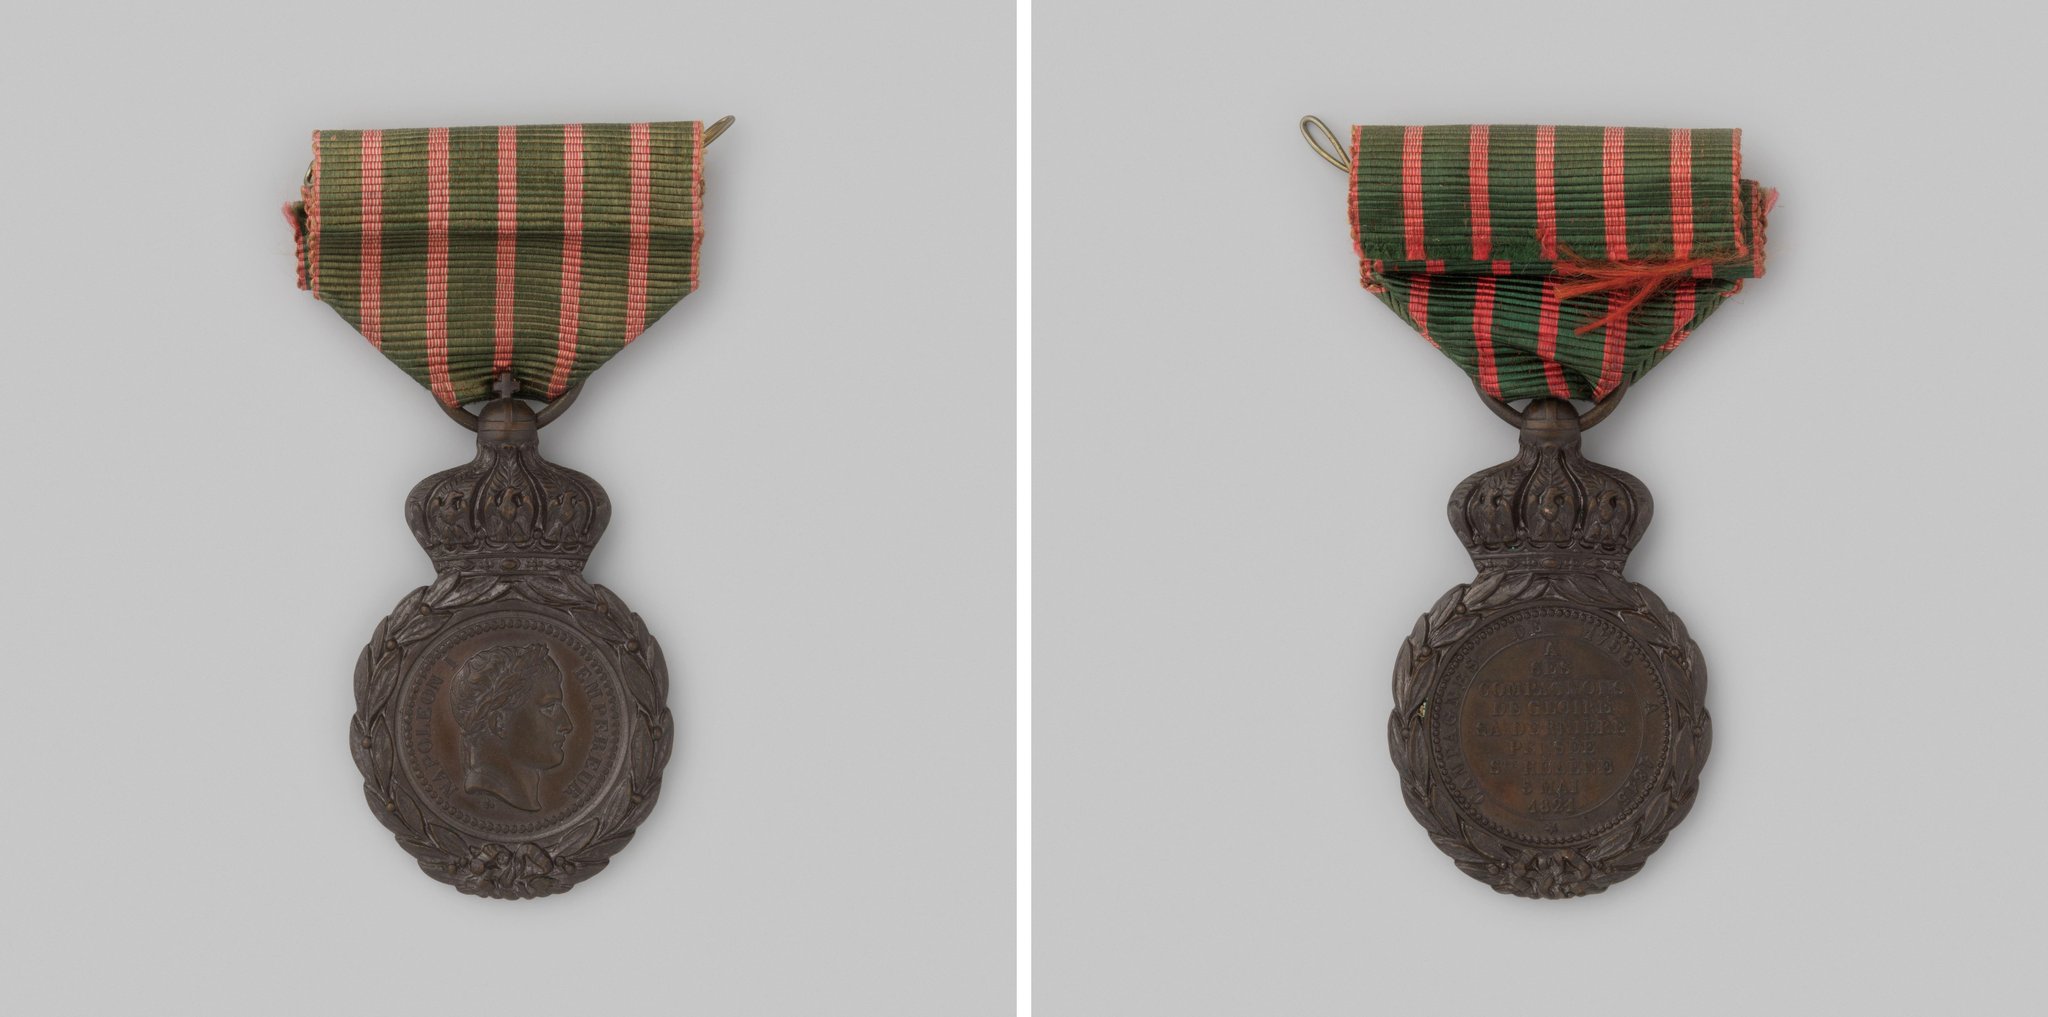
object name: ereteken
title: Gedenkpenning Sint-Helenamedaille, ingesteld door Napoleon III in 1857 en toegekend aan veteranen die tussen 1792 en 1815 in Franse dienst hadden gevochten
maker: désiré-albert barre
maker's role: graficus, medailleur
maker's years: 1818-1878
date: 1857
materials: bronze, textile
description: Bronzen draagpenning met knop, ring en lint, in bijbehorende doos met opdruk.